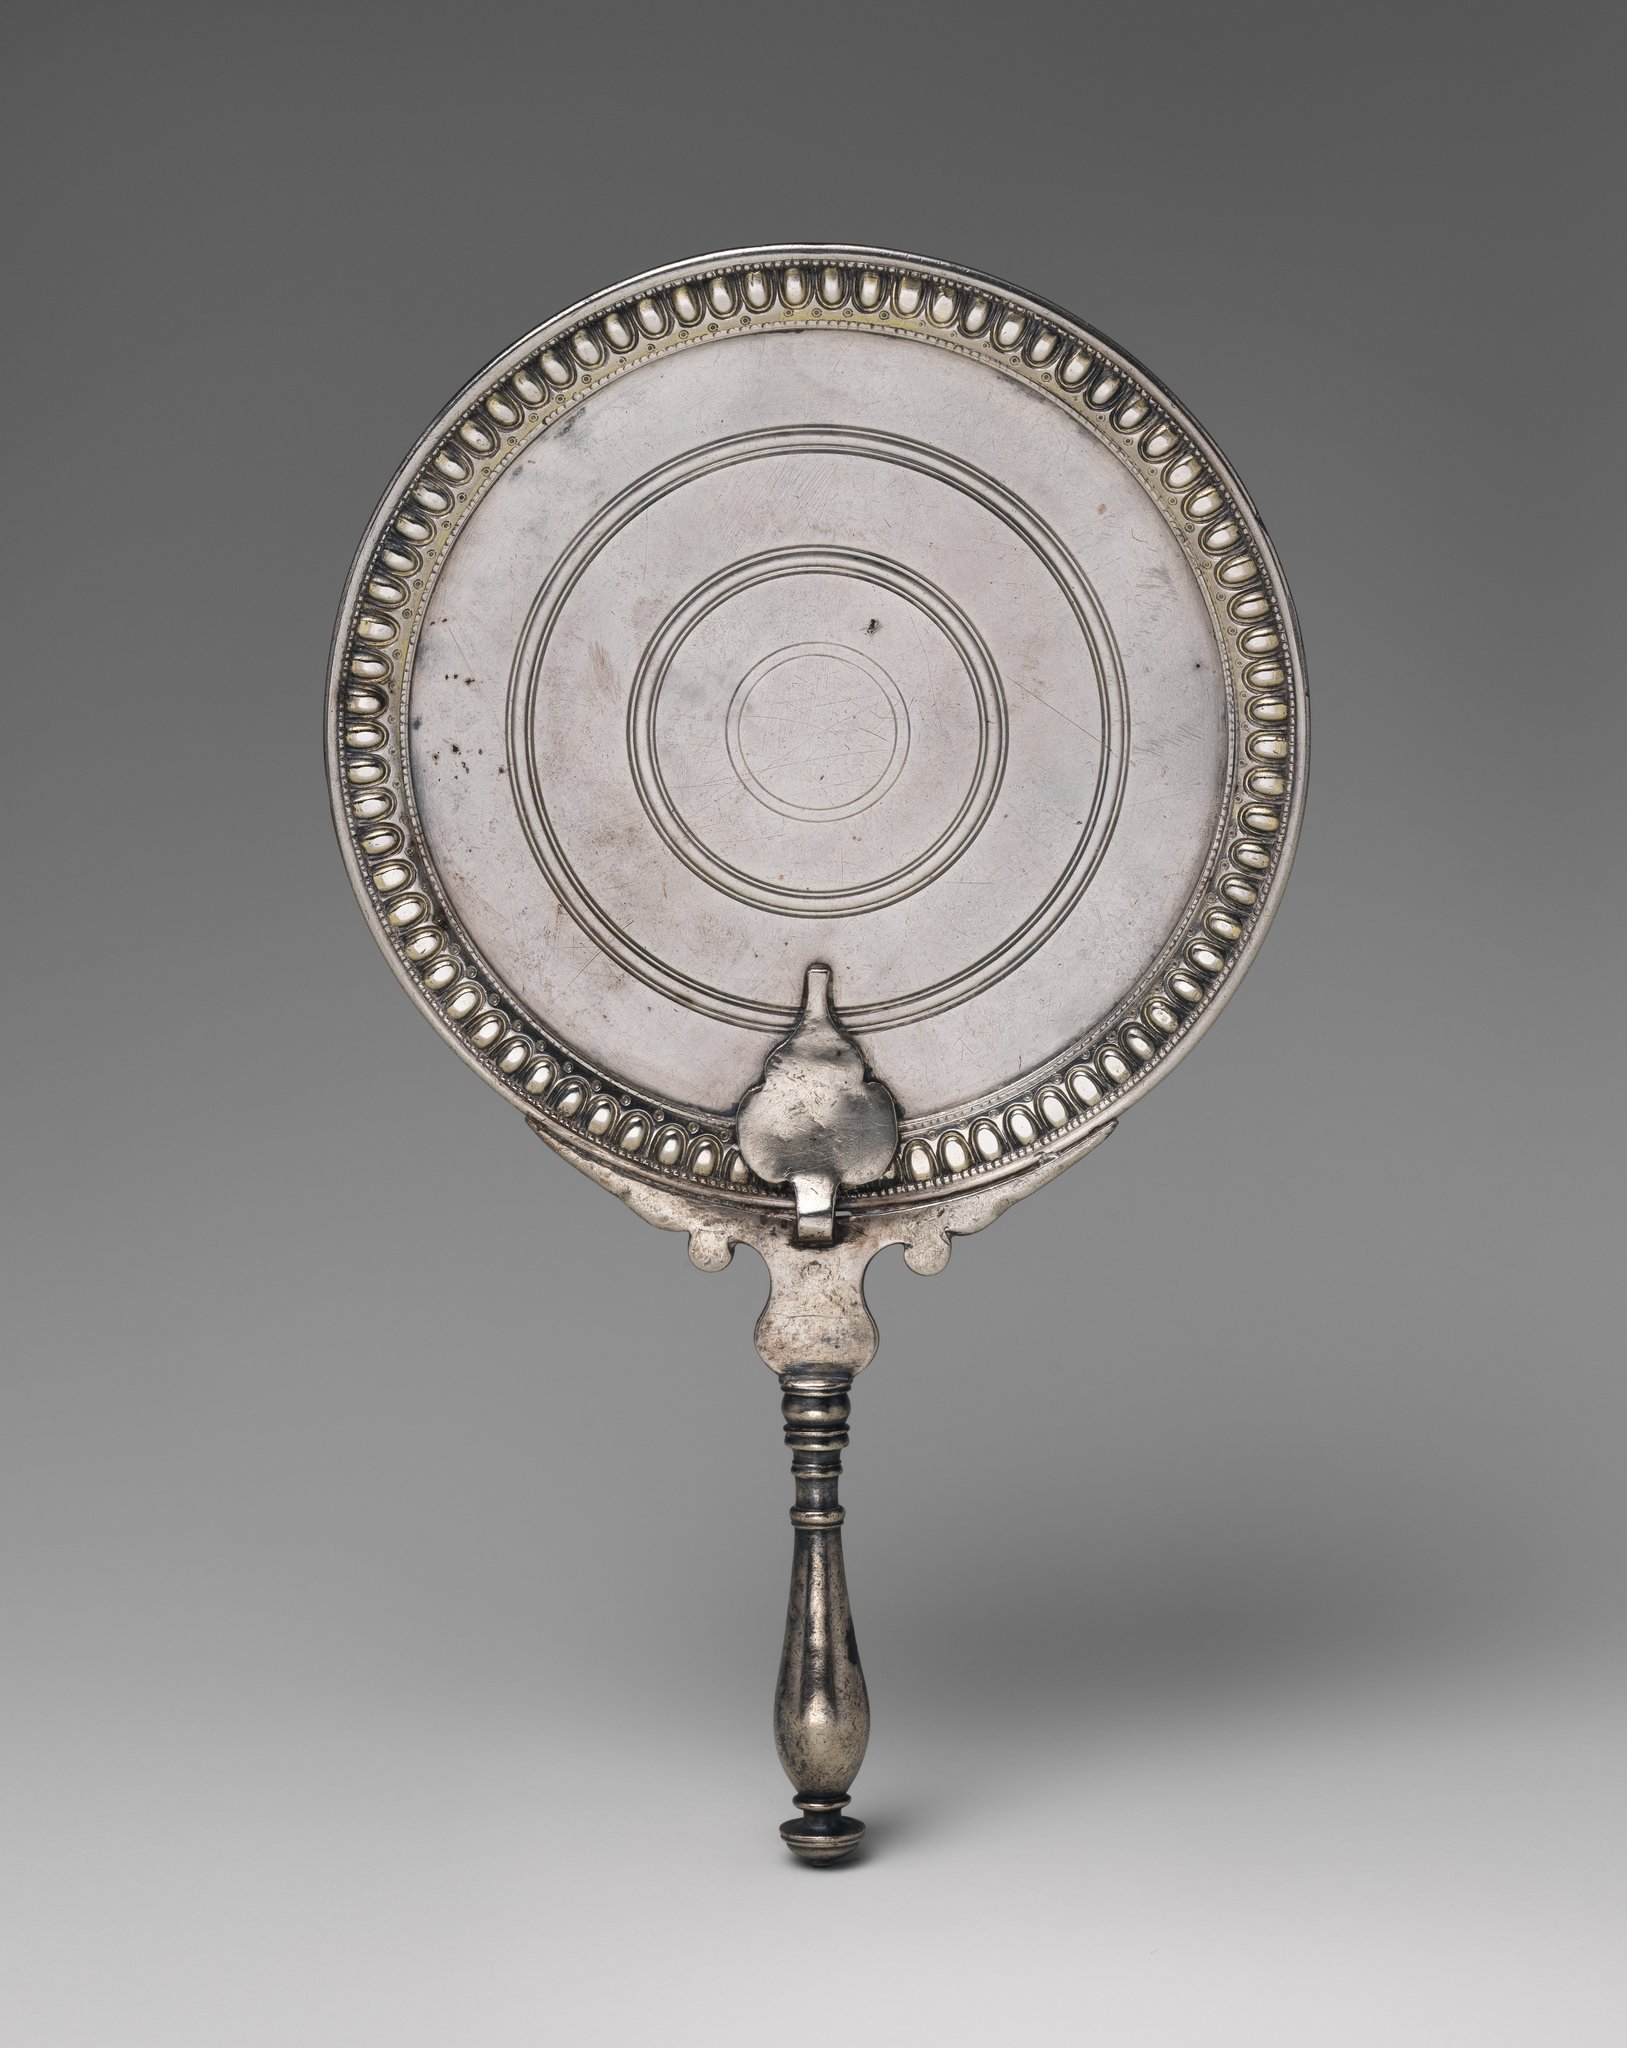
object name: mirror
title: Silver mirror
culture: roman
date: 1-100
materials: silver